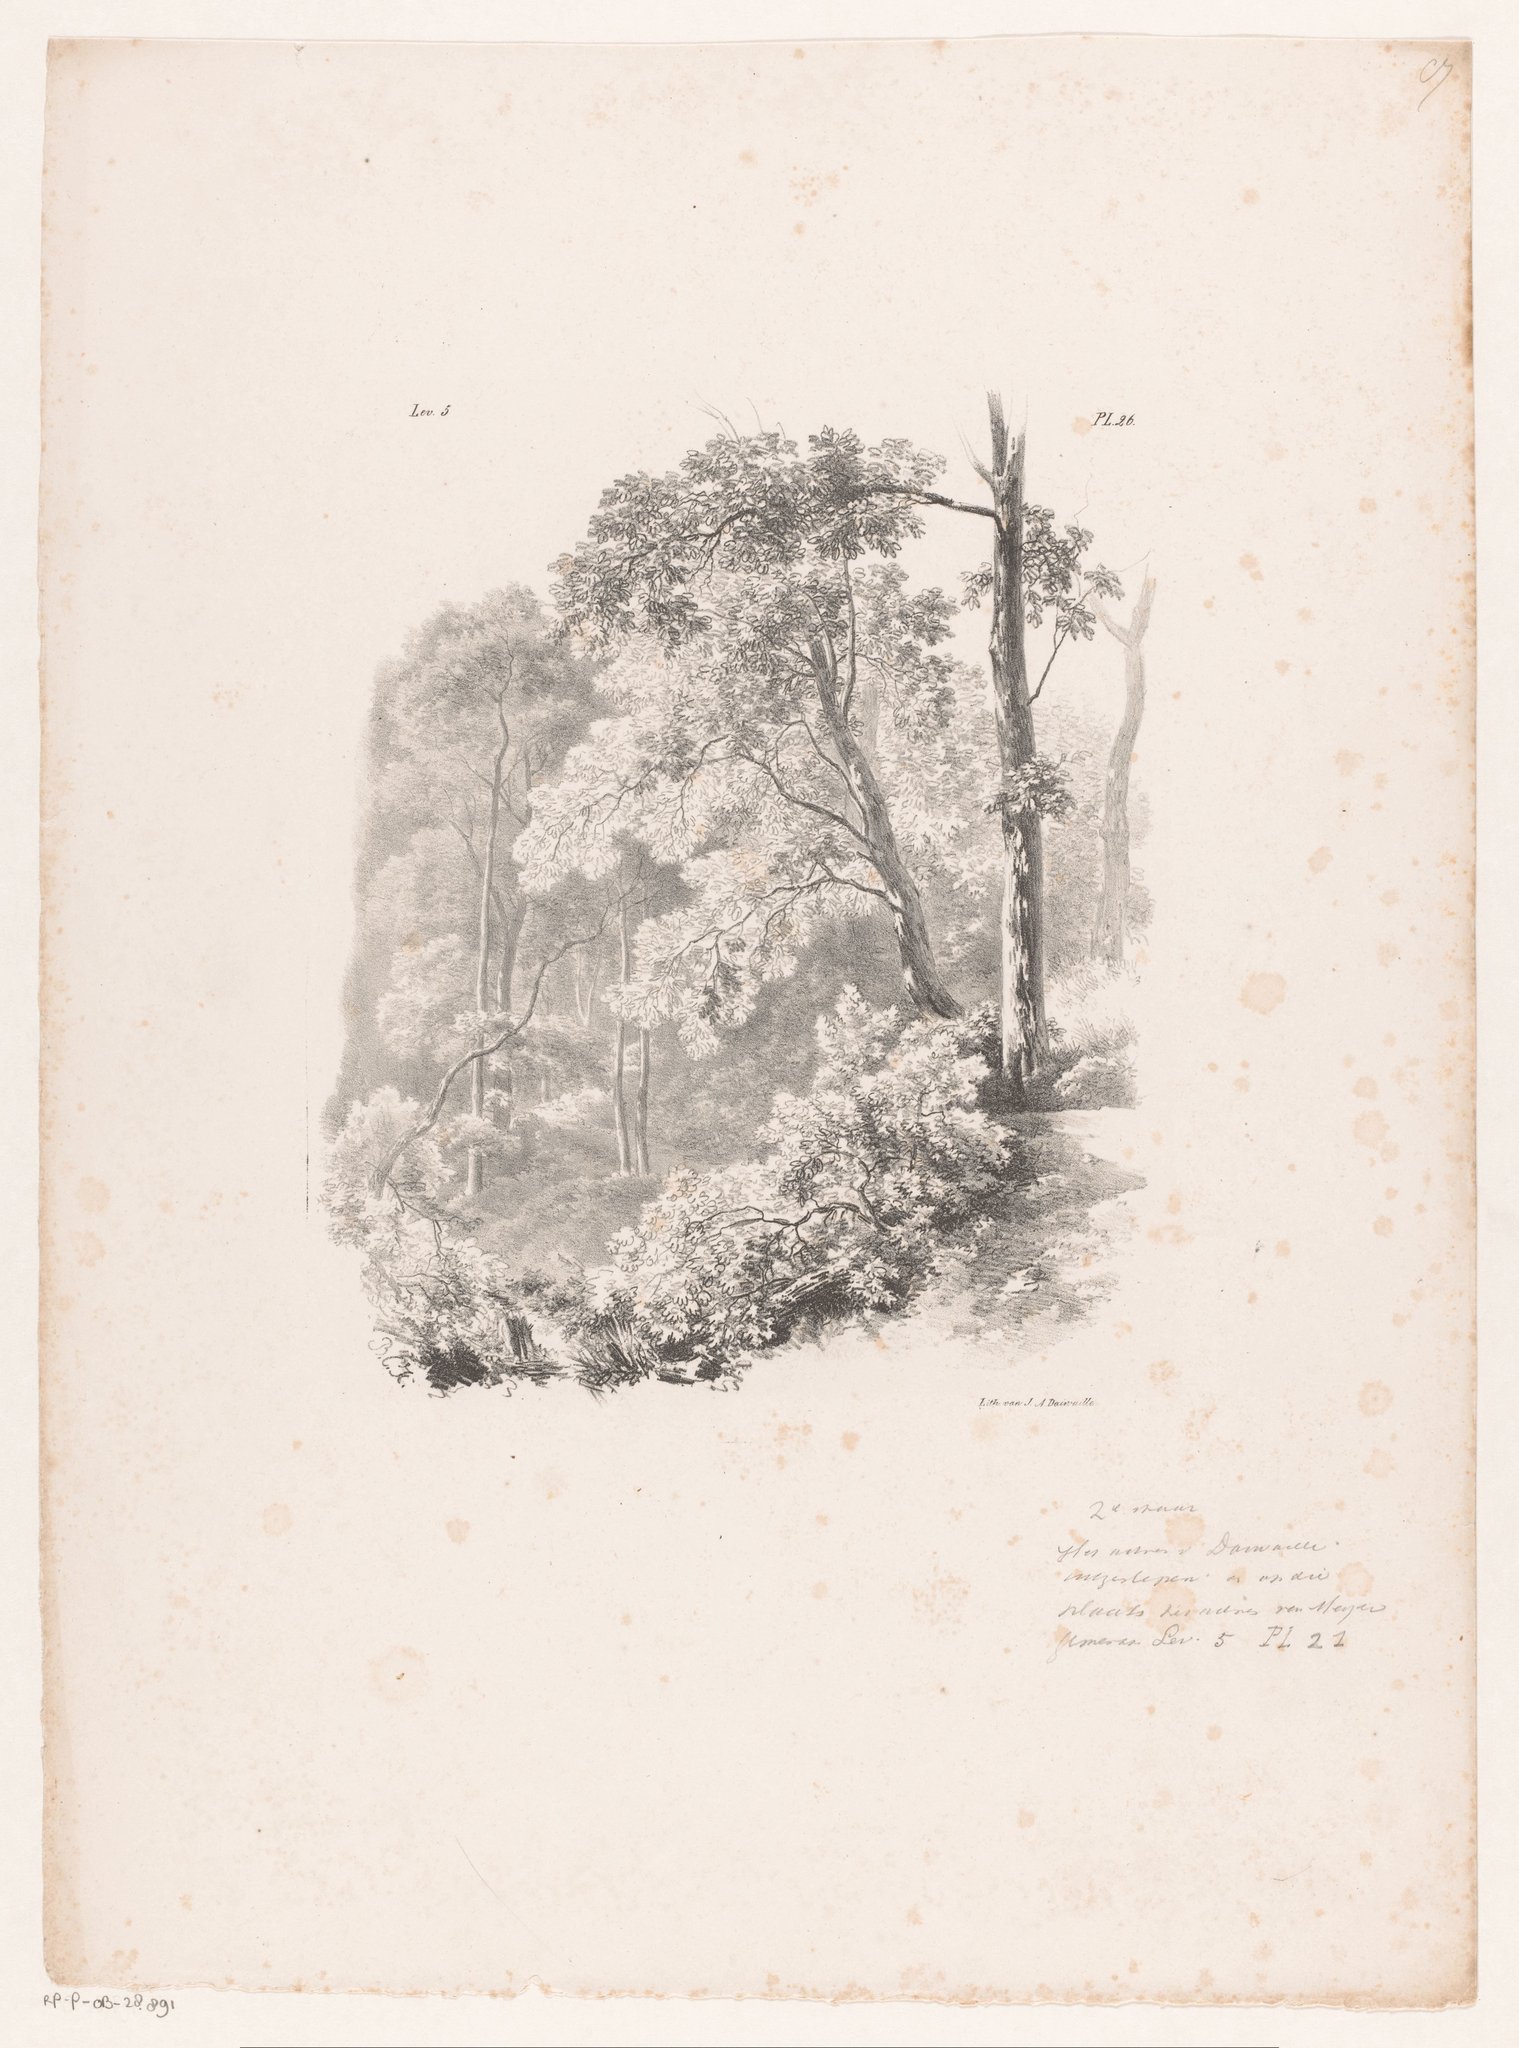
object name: print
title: Landschap studiën vijfde levering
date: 1829-1830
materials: paper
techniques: lithograph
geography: amsterdam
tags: trees, forest, wood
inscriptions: inscription: ‘2e staat / het adres v Daiwaille / ingeslepen en op die / plaats het adres van Meyer / genummerd Lev 5 PL 21’, collector's mark: Lugt 2228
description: In 1829 en 1830 gaf Koekkoek, samen met Daiwaille, zes cahiers uit met ieder zes prenten getiteld Landschapstudiën. Deze werden gebruikt in het tekenonderwijs. Vijftien jaar later werd deze reeks, in een andere samenstelling nogmaals uitgegeven door Meyer en Comp in Amsterdam. Zie: De Bruyn Kops, 1963 en Nollert, 1997.